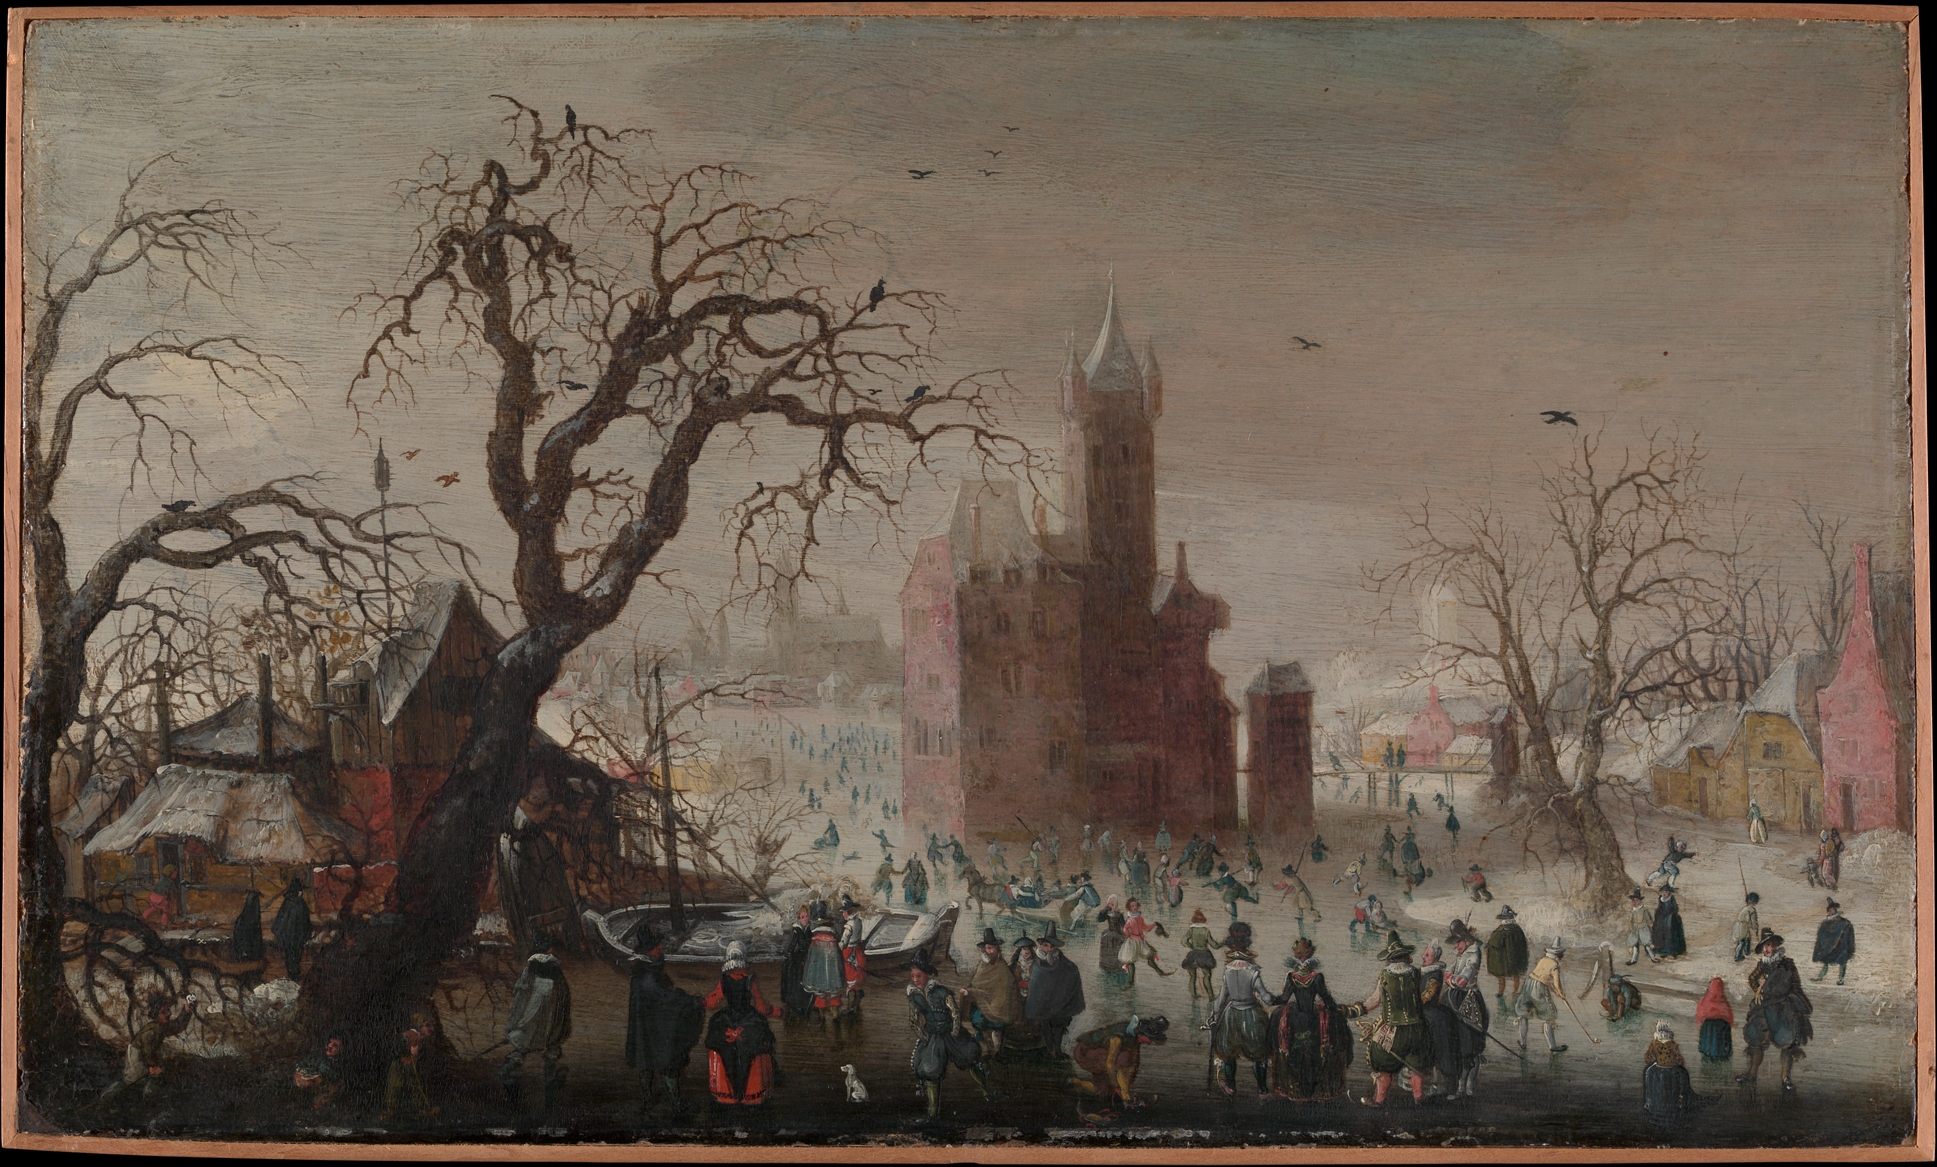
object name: painting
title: A Winter Landscape with Ice Skaters and an Imaginary Castle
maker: christoffel van den berghe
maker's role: artist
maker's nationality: dutch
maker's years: 1590-1628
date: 1615-1620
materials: oil, wood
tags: castles,men,women,skating,winter